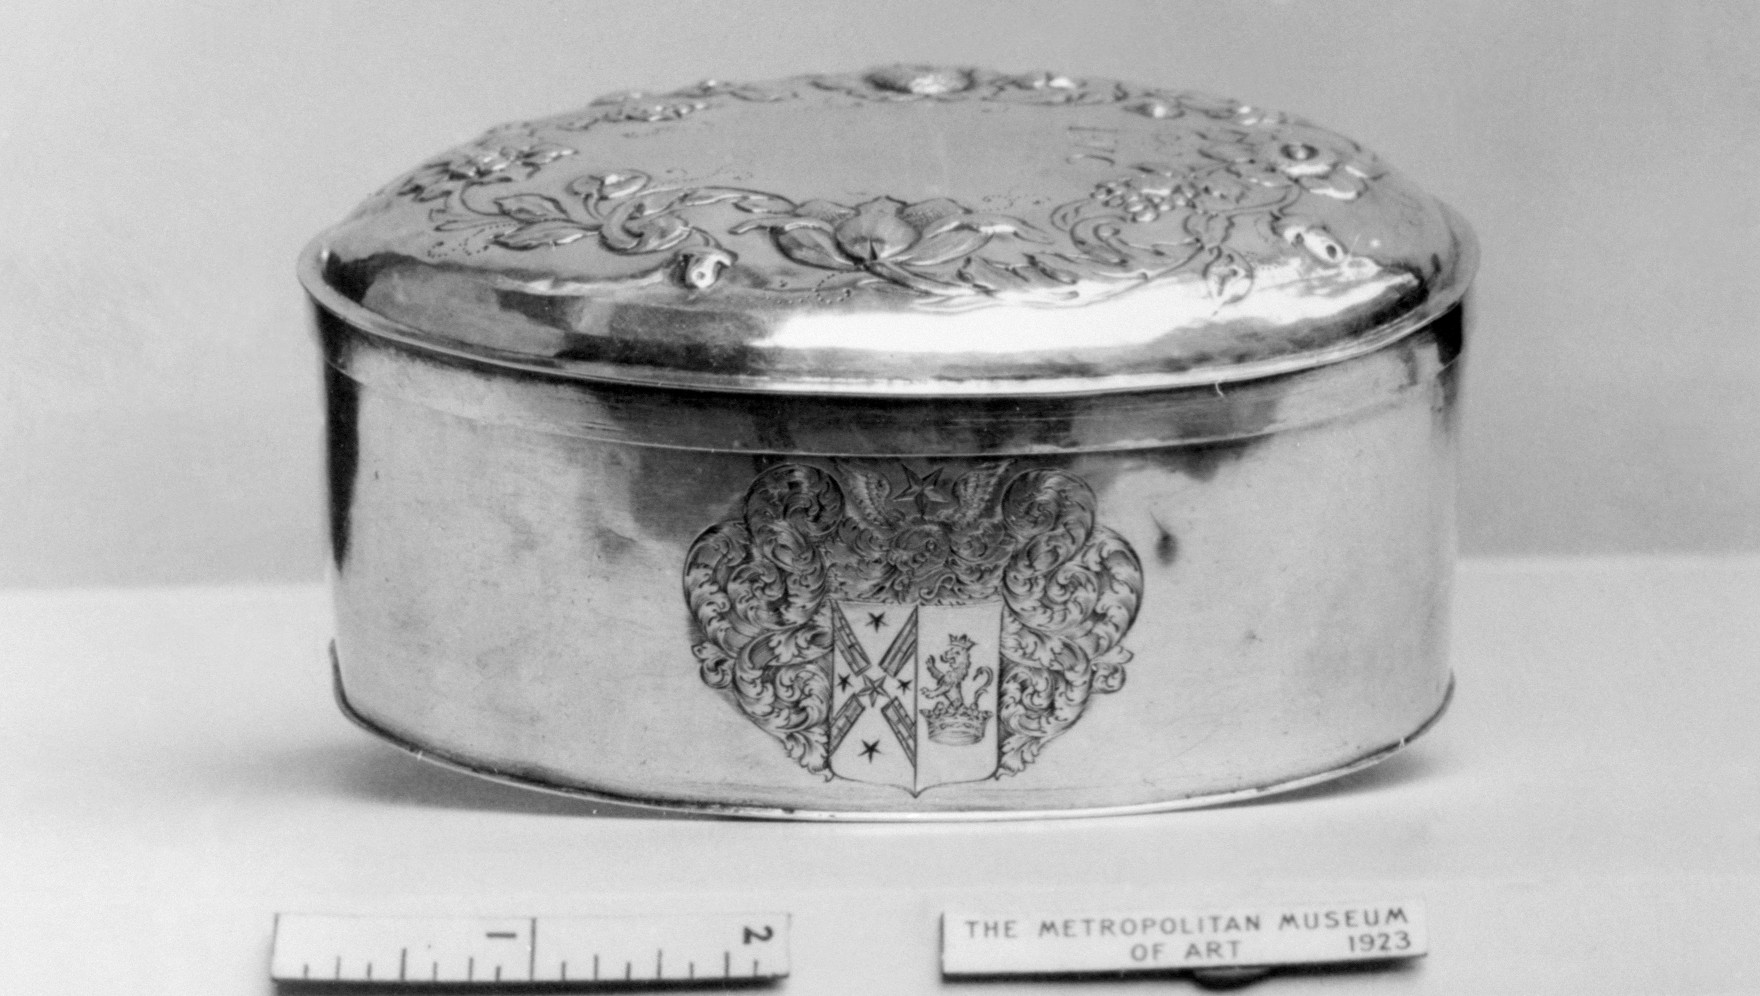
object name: box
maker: isaac le febure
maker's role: maker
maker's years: 1670-1692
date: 1668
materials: silver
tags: flowers,leaves,coat of arms